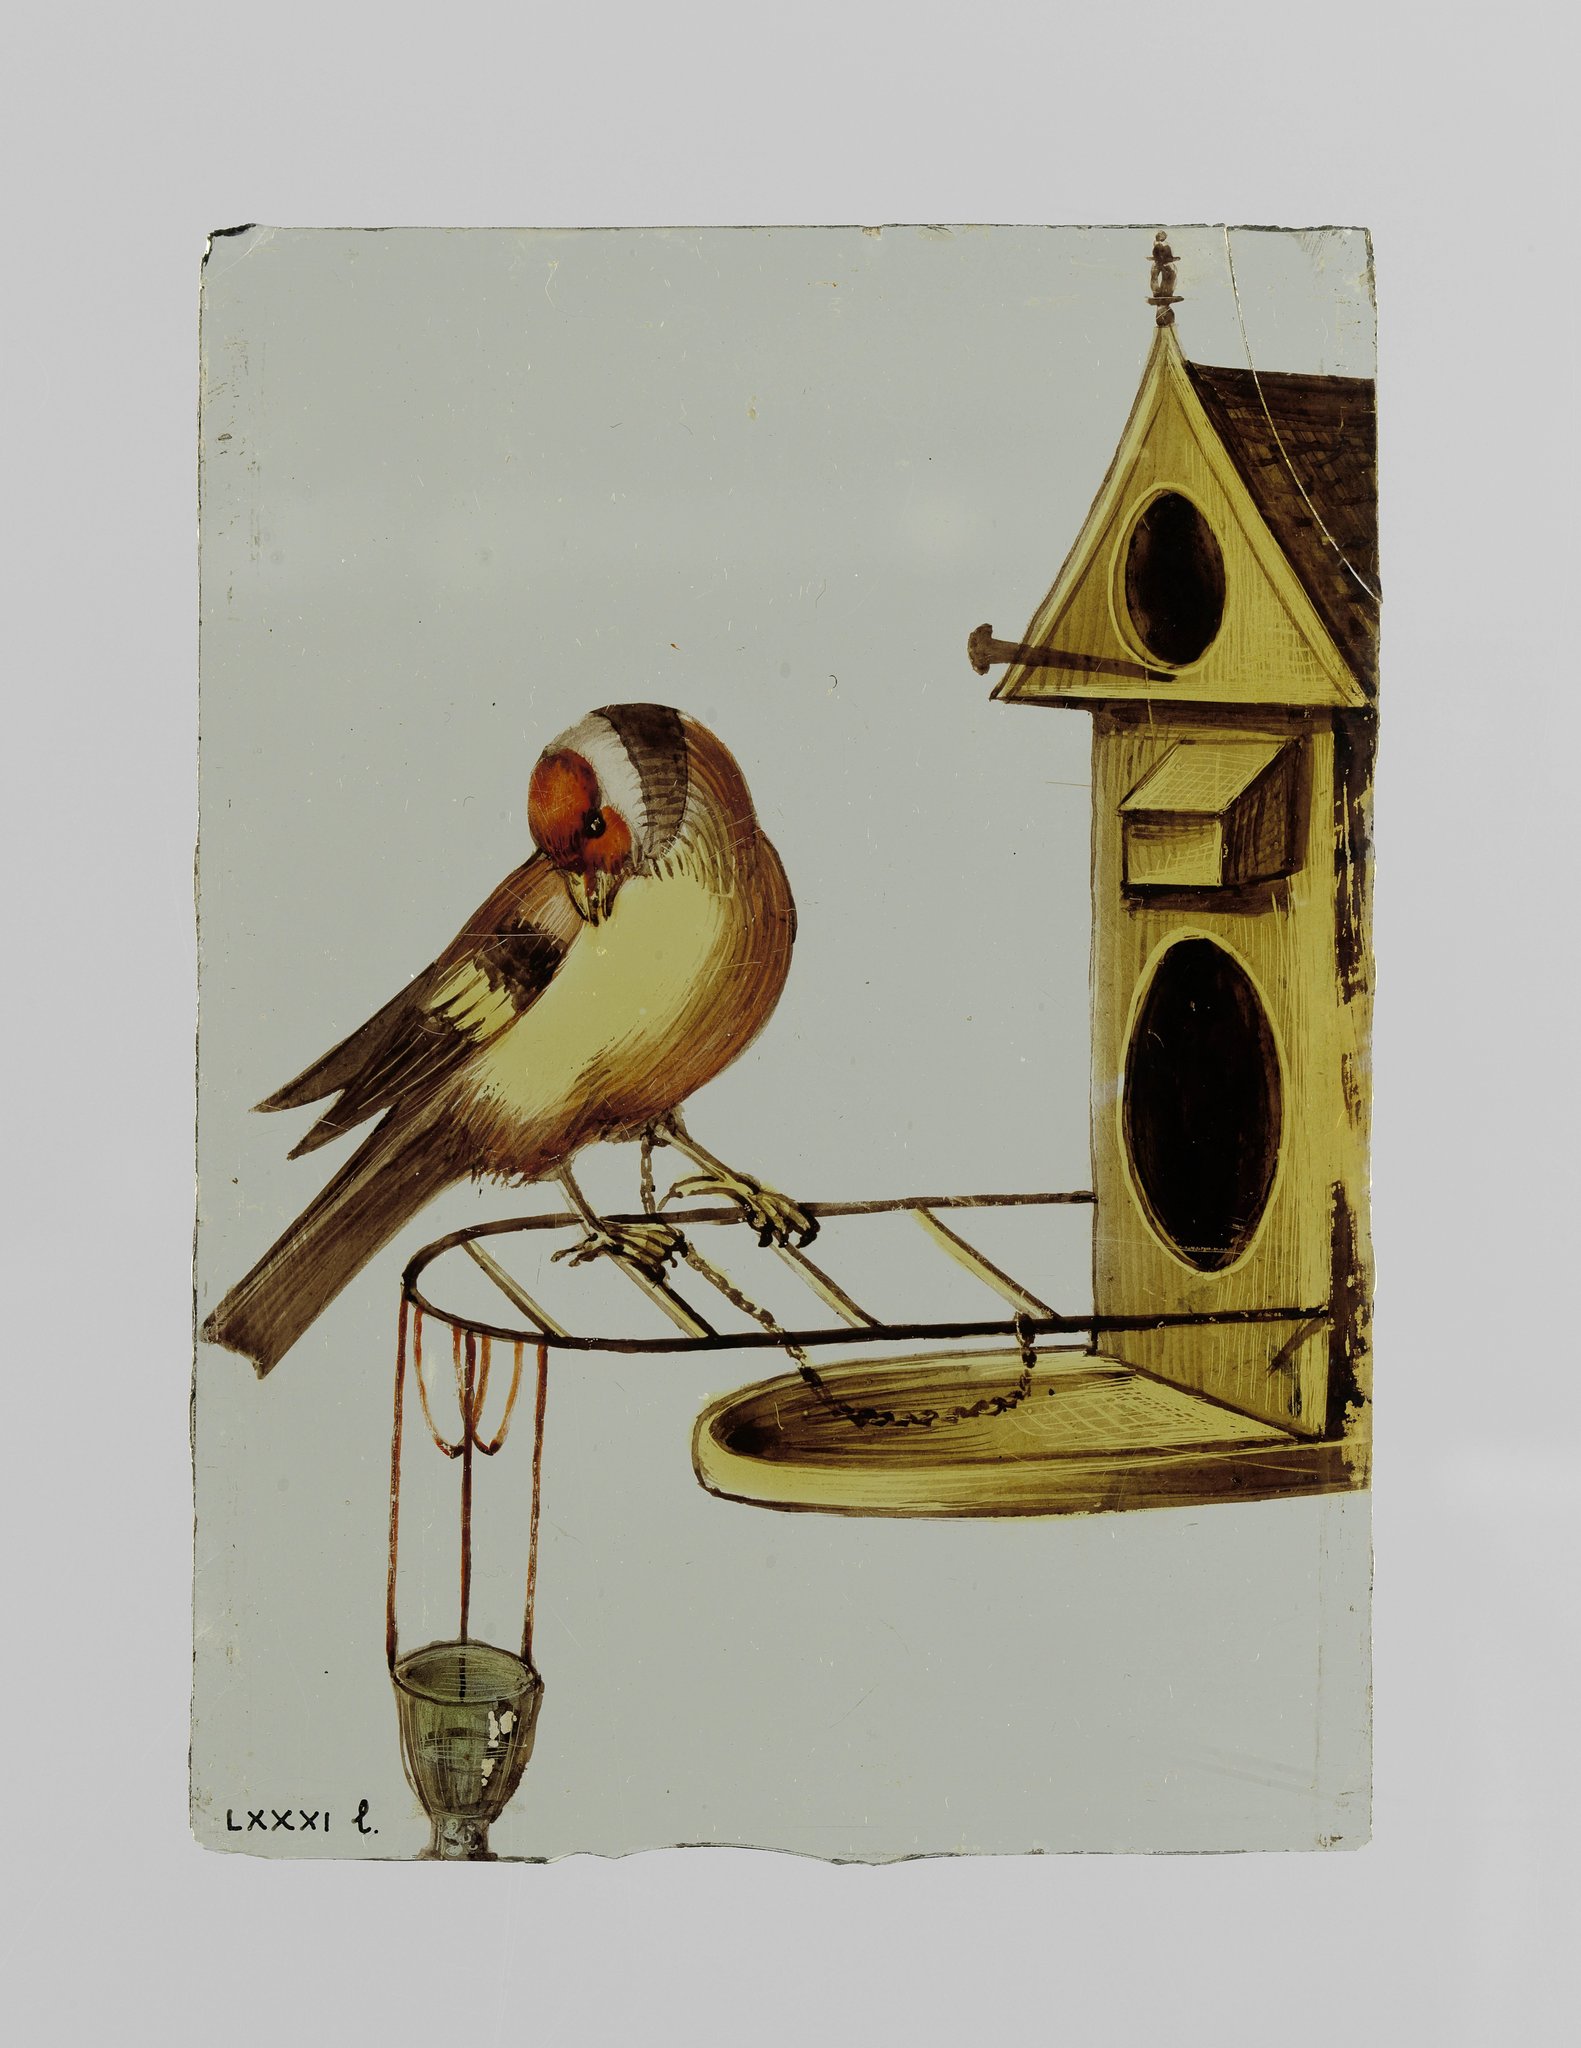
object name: light window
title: Ruit met een geketend puttertje voor een vogelhuisje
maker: Anonymous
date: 1650-1675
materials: glass, lead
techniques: enamel painting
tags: birds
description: Een ruit met emailschildering van een vogelhuisje met een geketend puttertje die achterom kijkt.